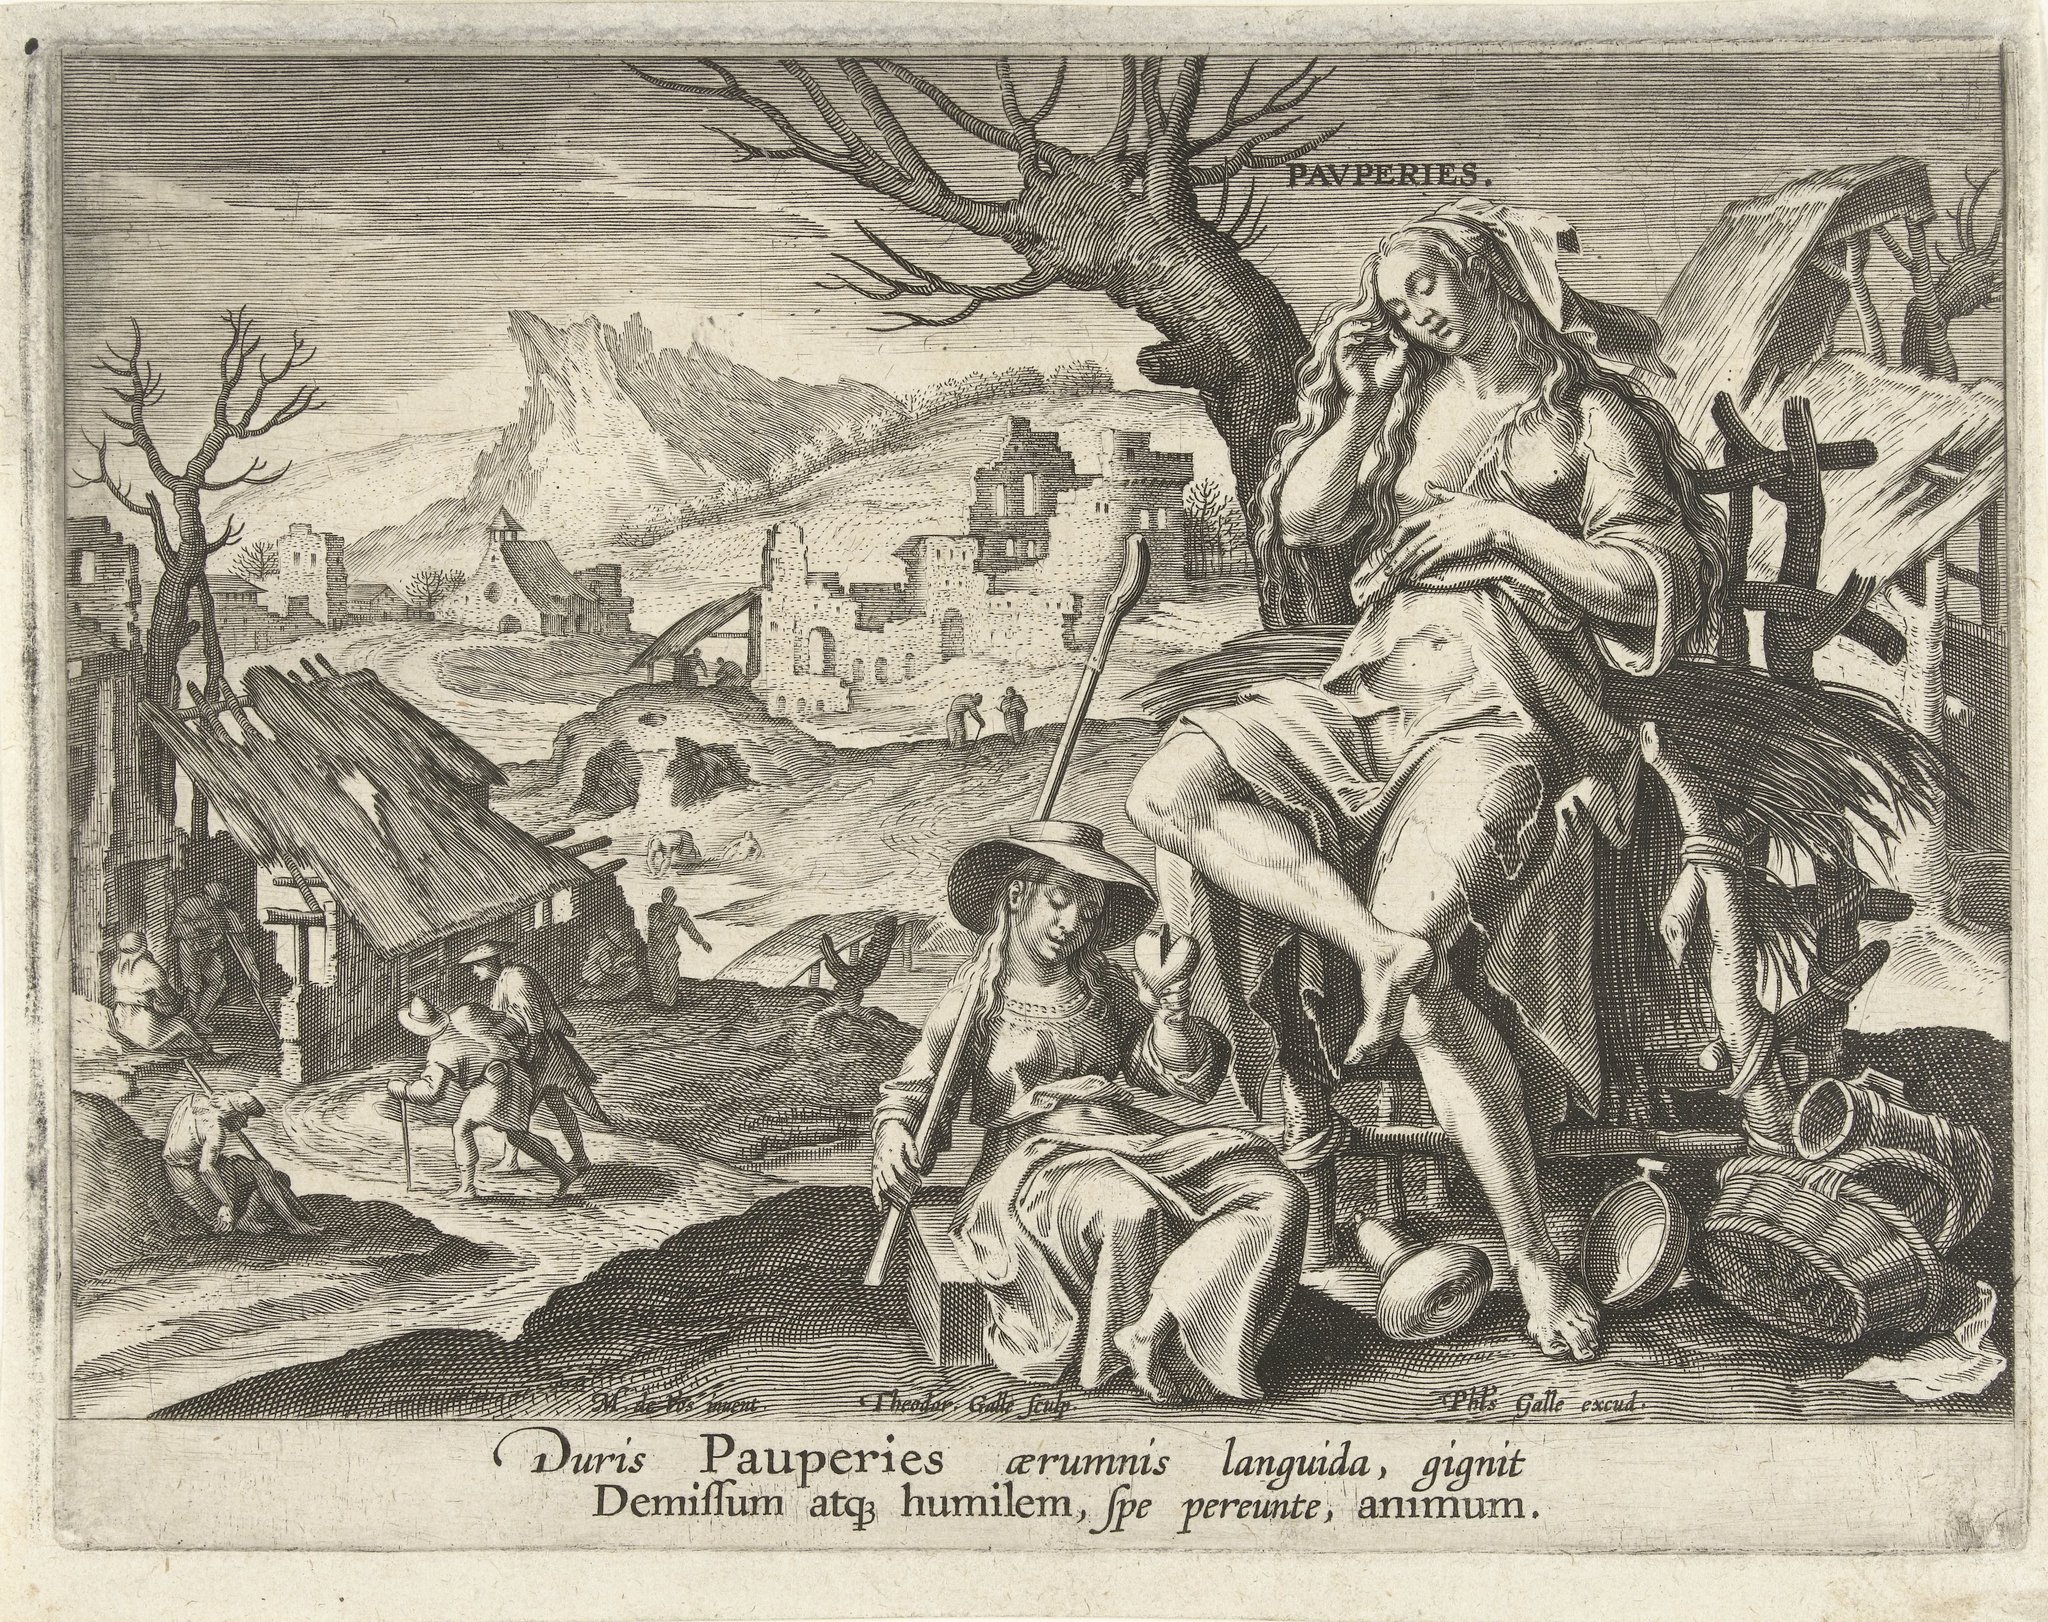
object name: print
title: Kringloop van het menselijk handelen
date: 1581-1633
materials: paper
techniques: engraving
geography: antwerp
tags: poverty; 'povertà', 'povertà del doni', 'povertà in uno ch'habbia bell'ingegno' (ripa), vicissitudes of life, beggar, humility; 'humiltà' (ripa)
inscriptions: collector's mark: Lugt 2228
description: De personificatie van Armoede (Pauperies), in vodden gekleed, zit in een winters landschap op een stoel gemaakt van boomtakken en stro. Achter haar een armzalig huisje. Aan haar voeten zit Nederigheid (Humilitas): een meisje met een herdersstaf en een gekliefd hart in haar handen. Links op de achtergrond een armoedig dorp en bedelaars. De prent heeft een Latijns onderschrift en is deel van een serie over de kringloop van het menselijk handelen.